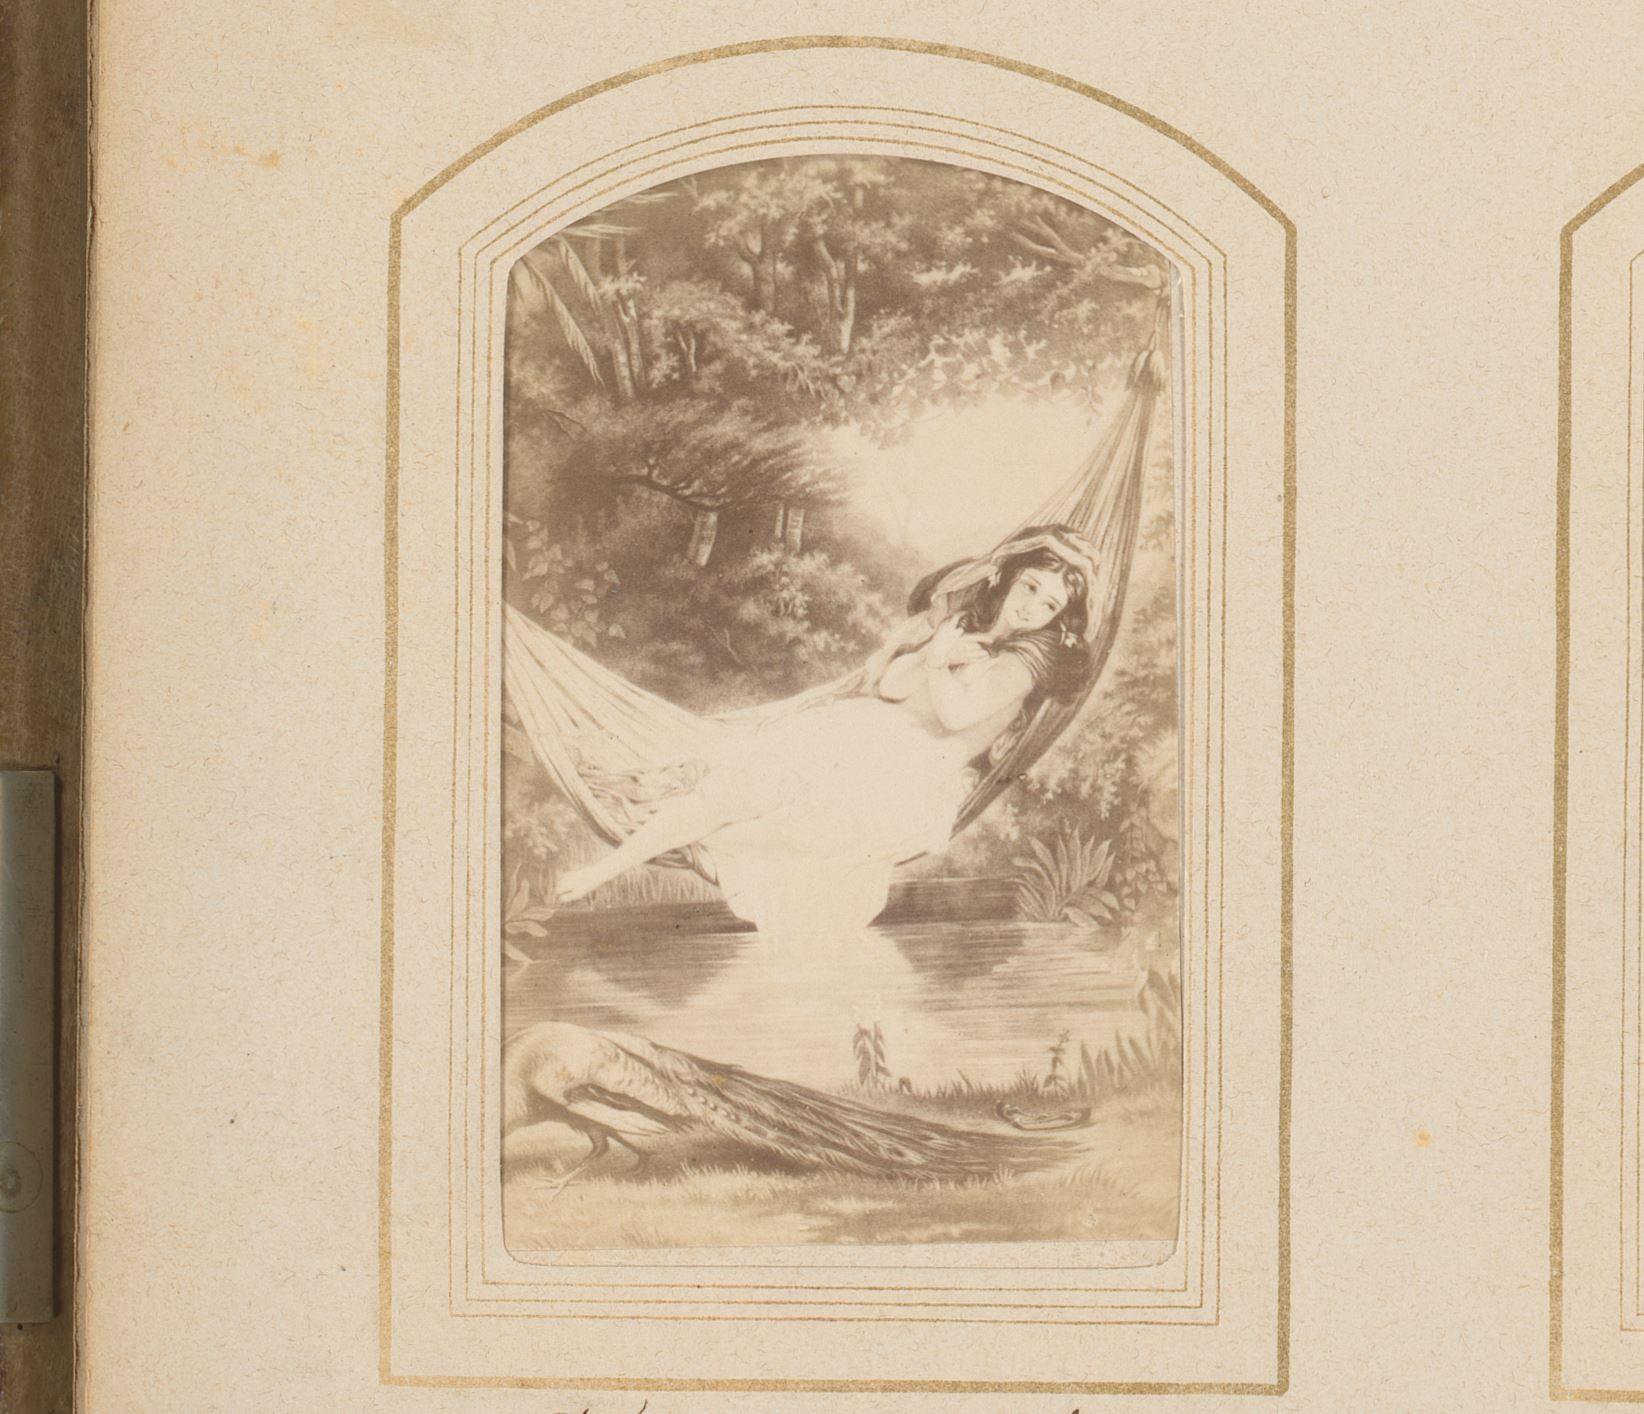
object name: photograph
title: Fotoreproductie van Sara im Bade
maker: Anonymous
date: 1870-1900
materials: cardboard, photographic support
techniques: albumen print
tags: hammock, adult woman, landscapes with waters, waterscapes, seascapes (in the temperate zone), painting, drawing and the graphic arts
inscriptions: annotation: ‘Sara im Bade’, inscription: ‘Müller/ 1064./ Sara la baigneuse./ Sara im Bade./ Sara in the bath.’